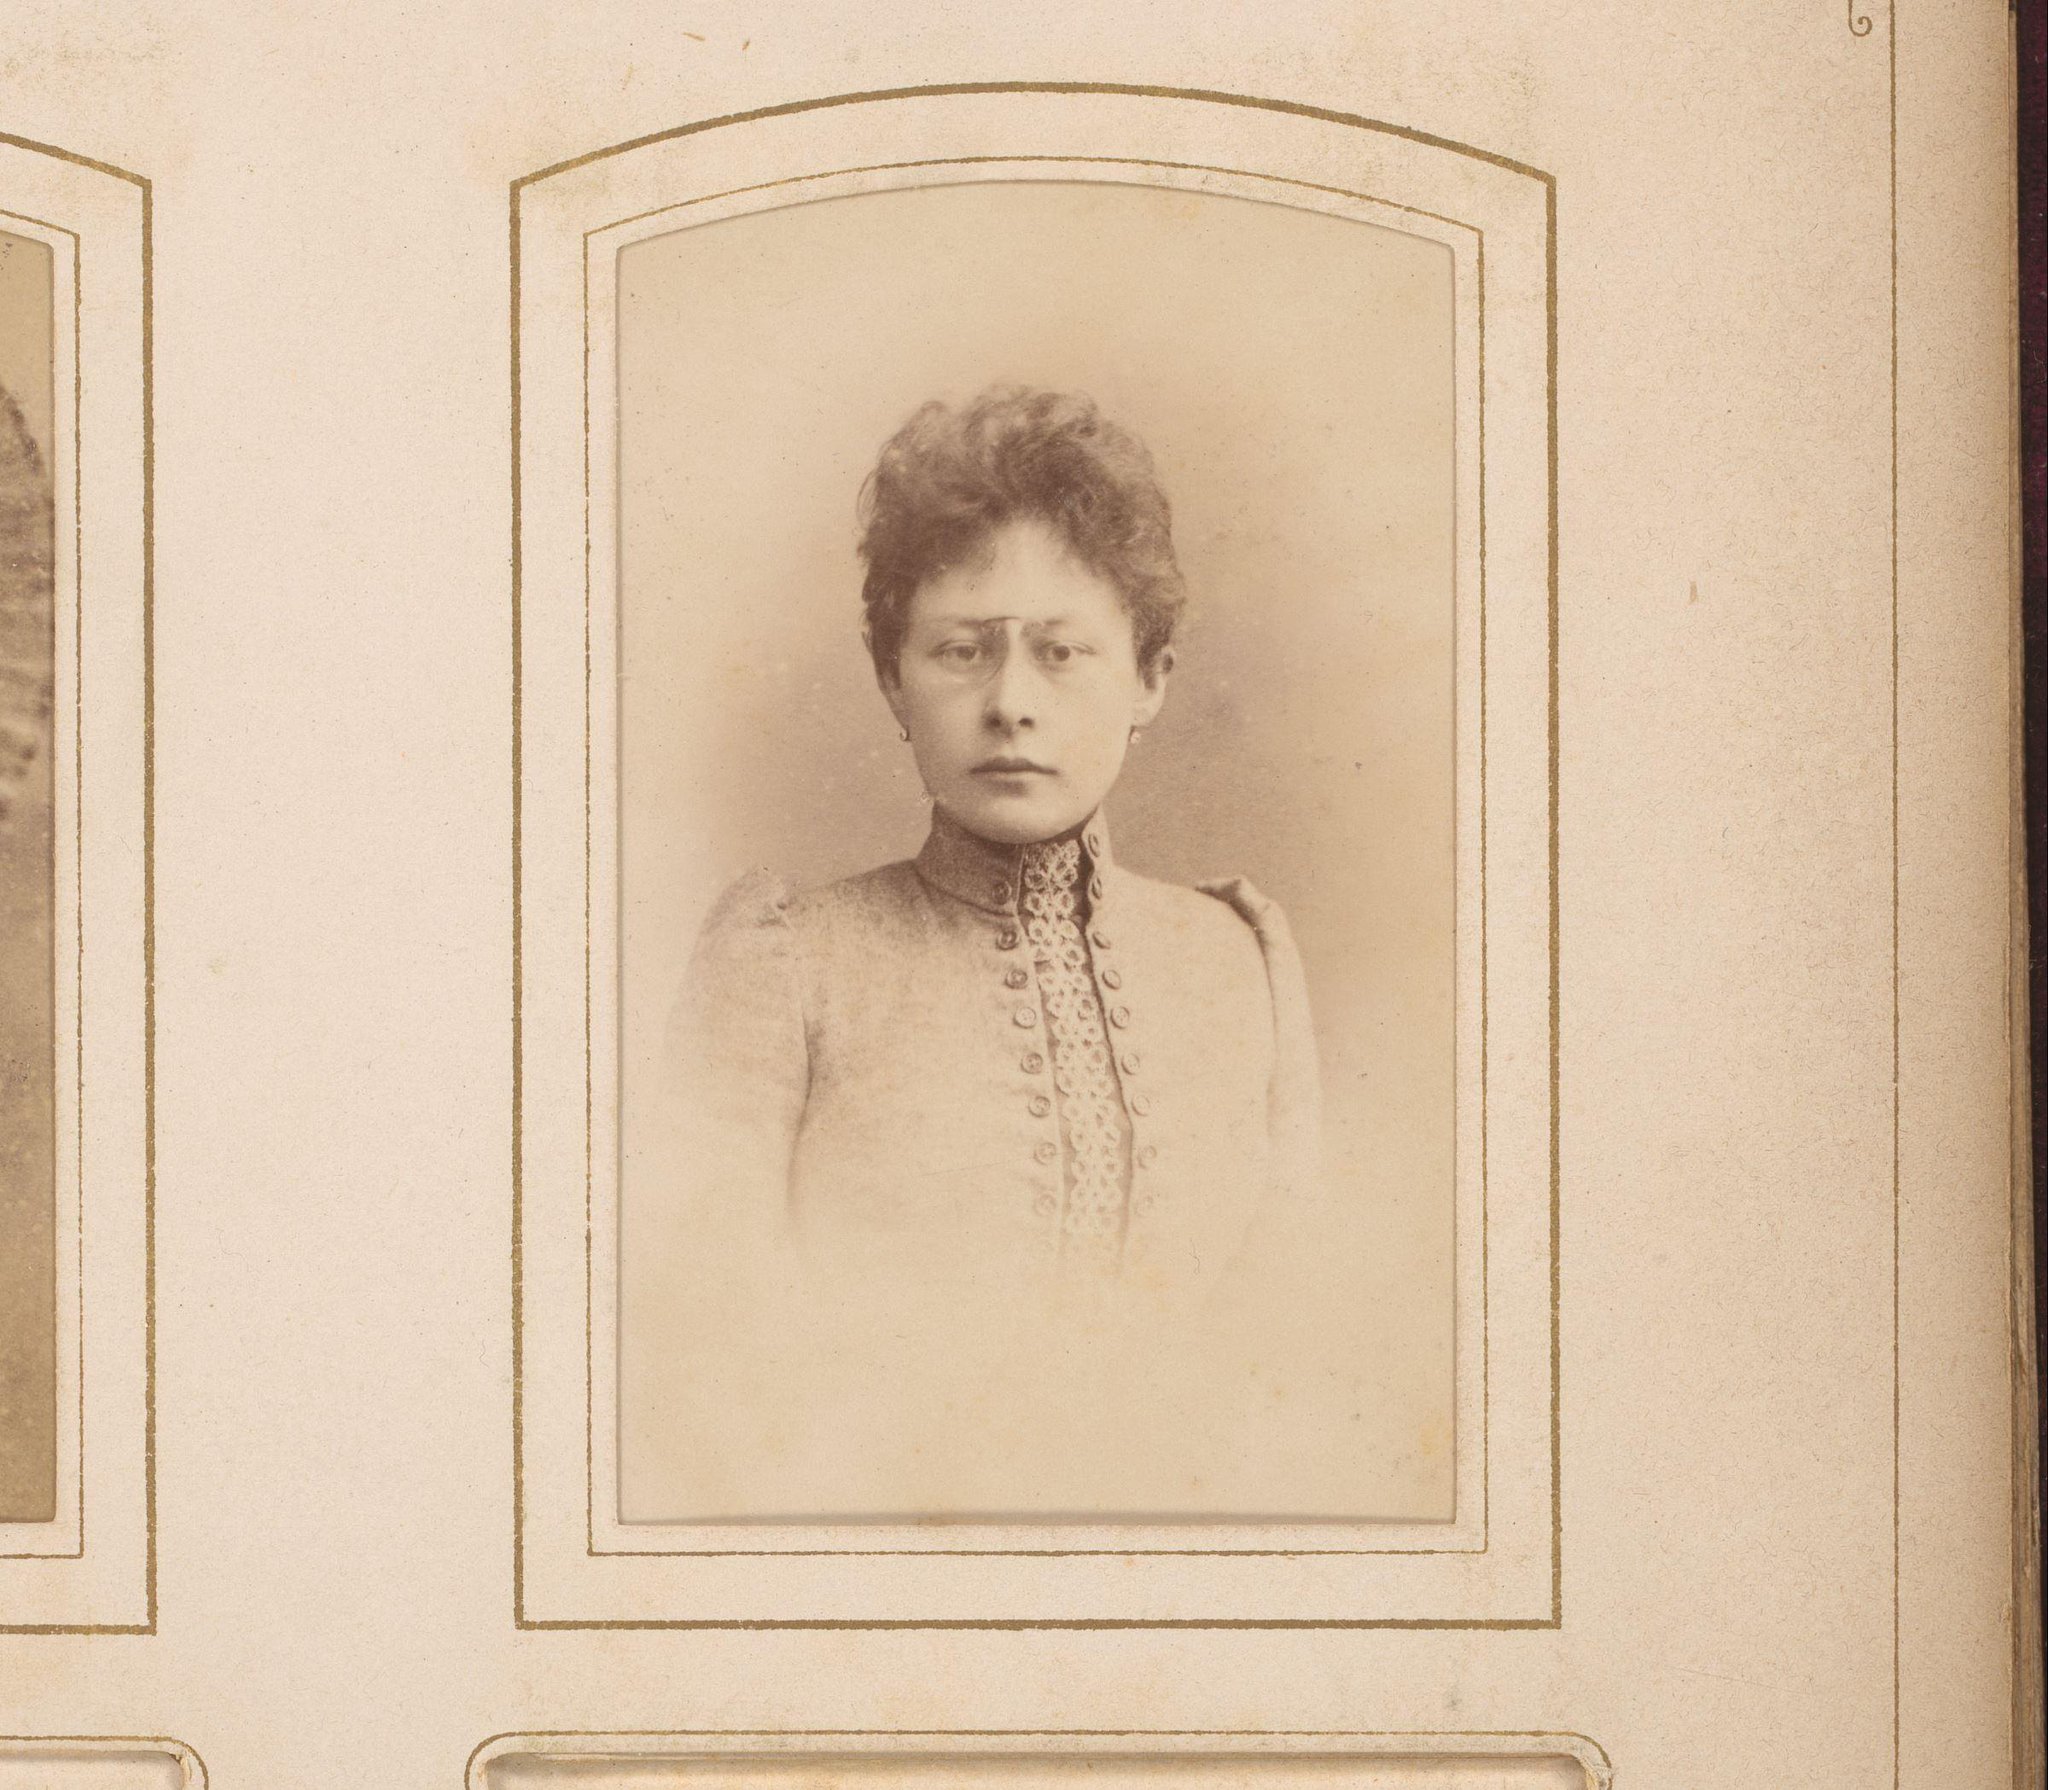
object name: photograph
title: Portret van een vrouw met bril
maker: adolphe zimmermans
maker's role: fotograaf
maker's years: 1858-1922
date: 1884-1900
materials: cardboard, photographic support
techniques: albumen print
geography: the hague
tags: eyeglasses, spectacles, historical persons - bb - woman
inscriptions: inscription: ‘Adolphe Zimmermans/ de Riemerstraat 21,/ La Haye./ Specialité pour les agrandissements/ au charbon inaltérable.’